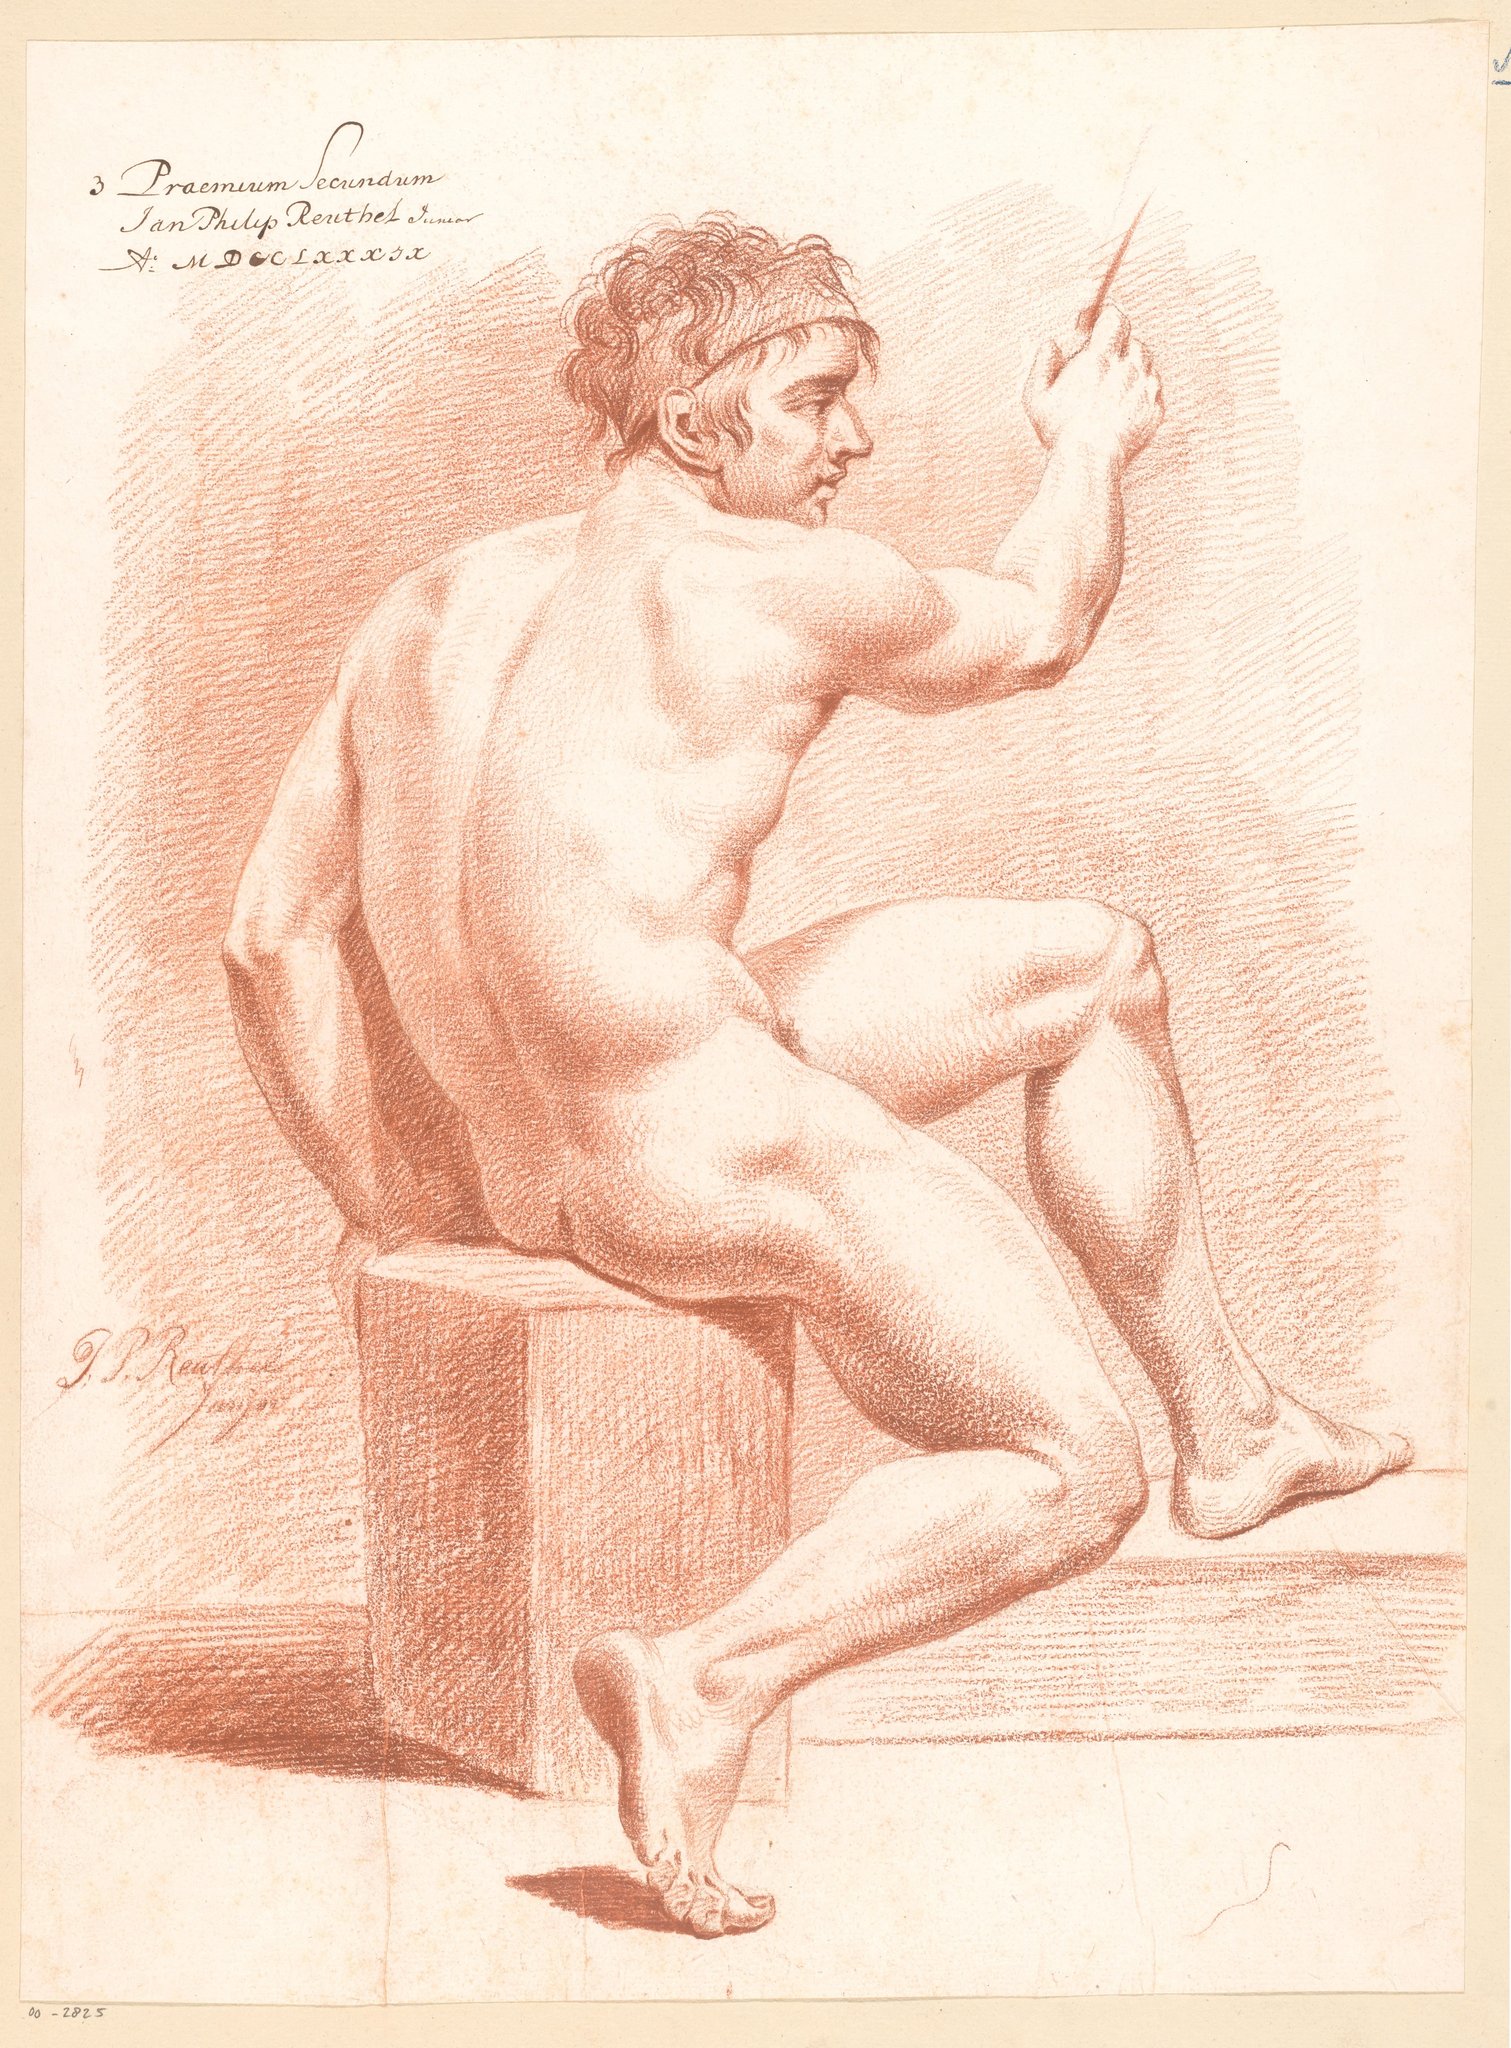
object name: drawing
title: Zittend mannelijk naakt, op de rug gezien (2e prijs 1789)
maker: jan philip reuthel jr.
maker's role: draughtsman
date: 1789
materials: chalk, charcoal, paper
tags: sitting figure (+ nude human being)